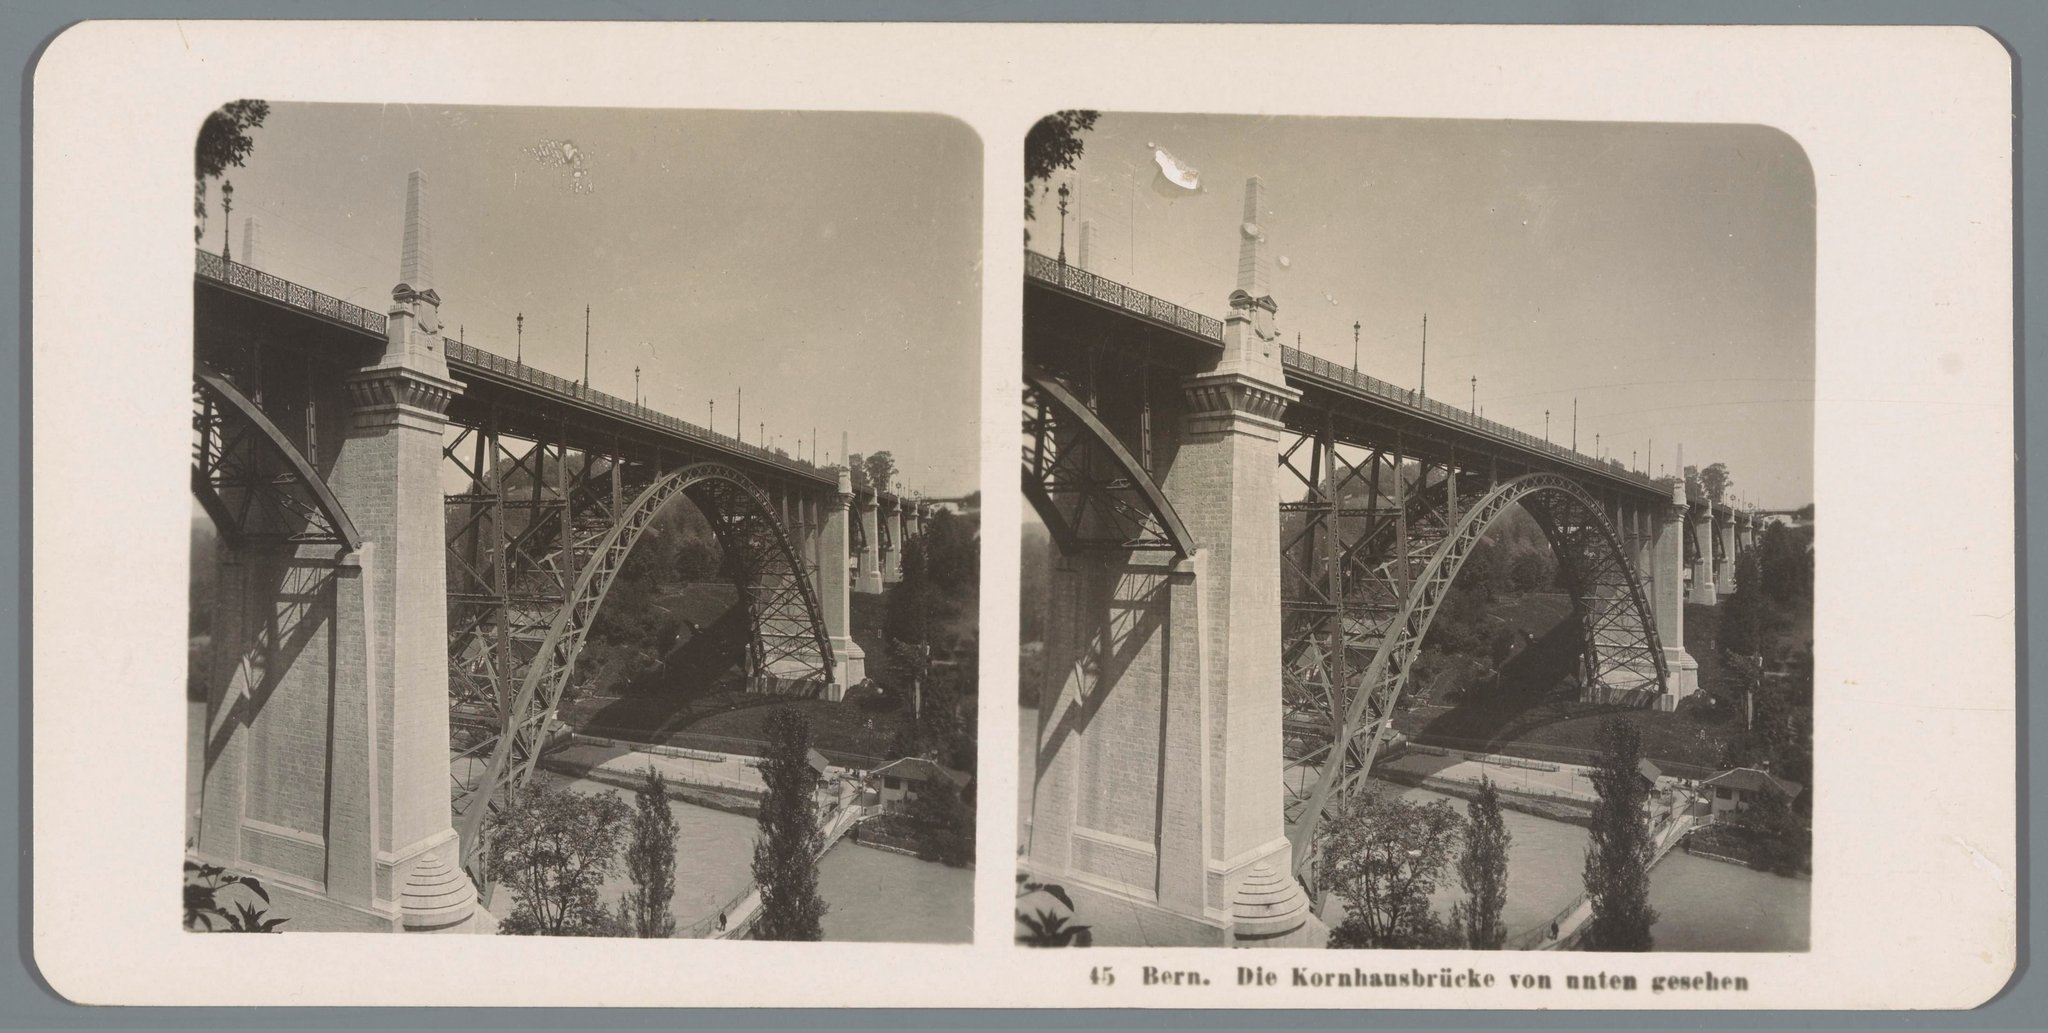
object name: stereograph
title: Bern. Die Kornhausbrücke von unten gesehen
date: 1906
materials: cardboard, photographic support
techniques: gelatin silver print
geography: bern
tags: bridge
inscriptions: inscription: ‘Neue Photographische Gesellschaft A. G., Steglitz-Berlin 1906.’, number: ‘45’